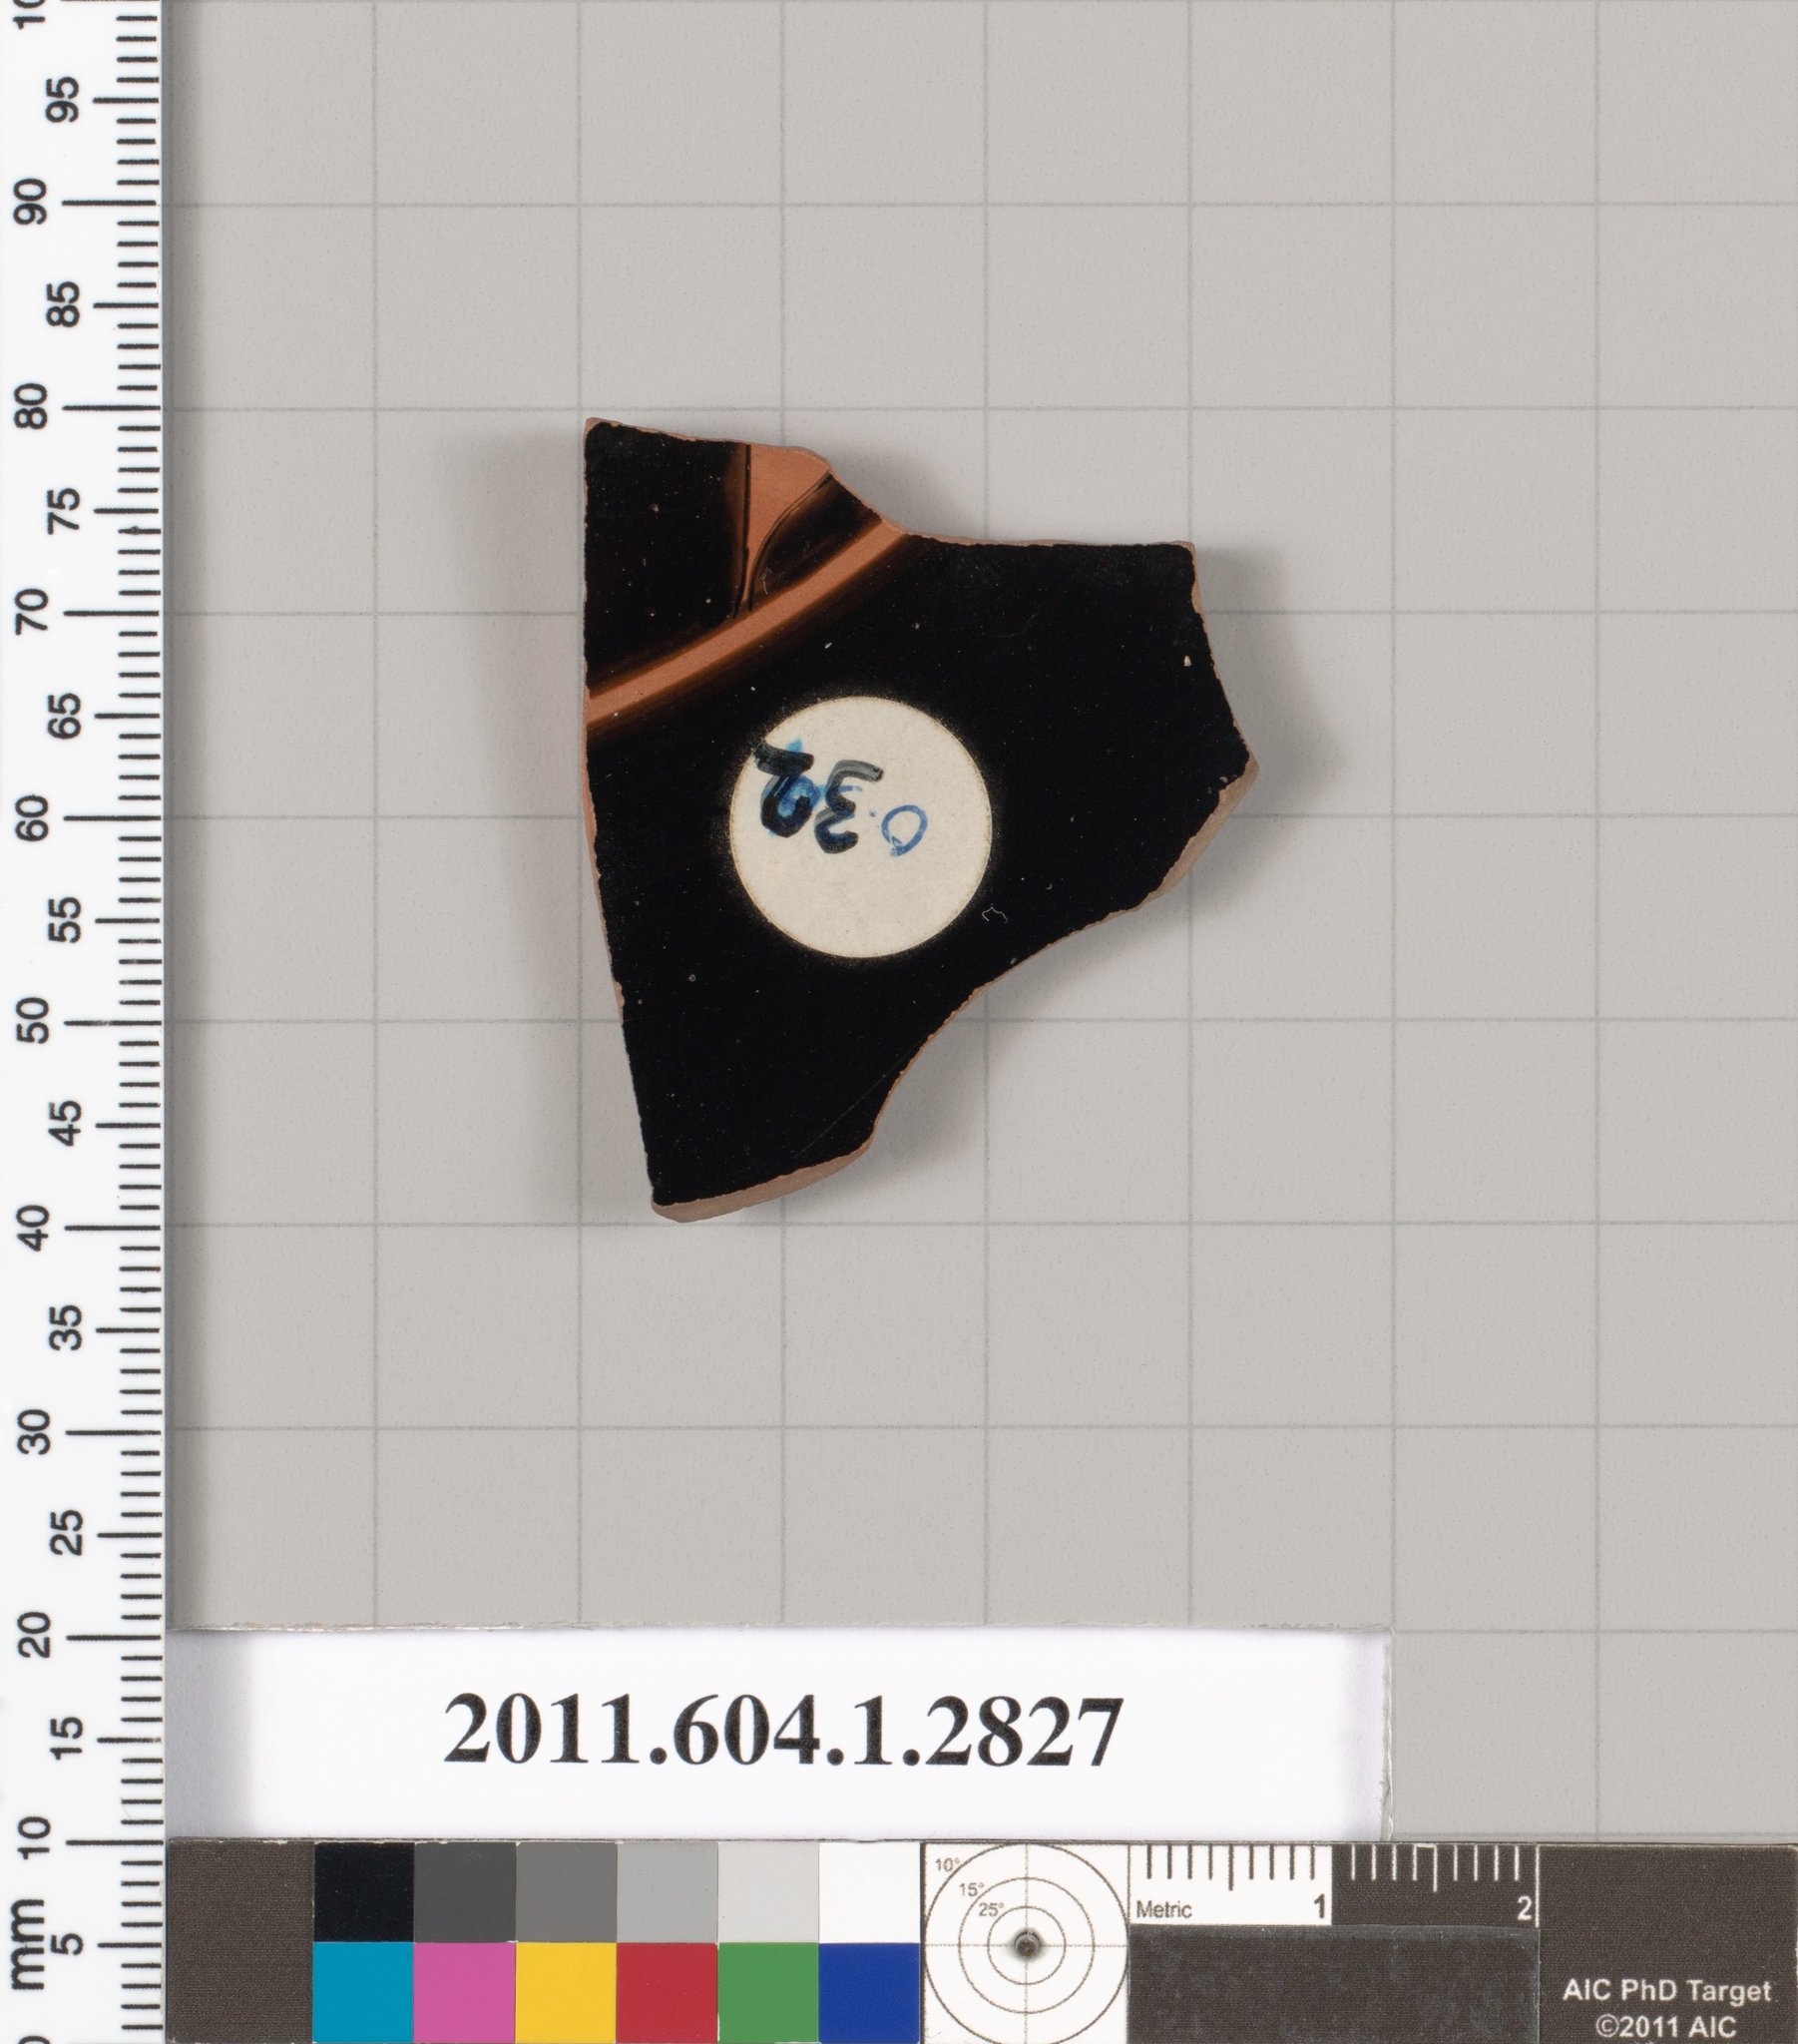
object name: kylix fragment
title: Terracotta fragment of a kylix (drinking cup)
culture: greek, attic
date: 520-500 BCE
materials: terracotta